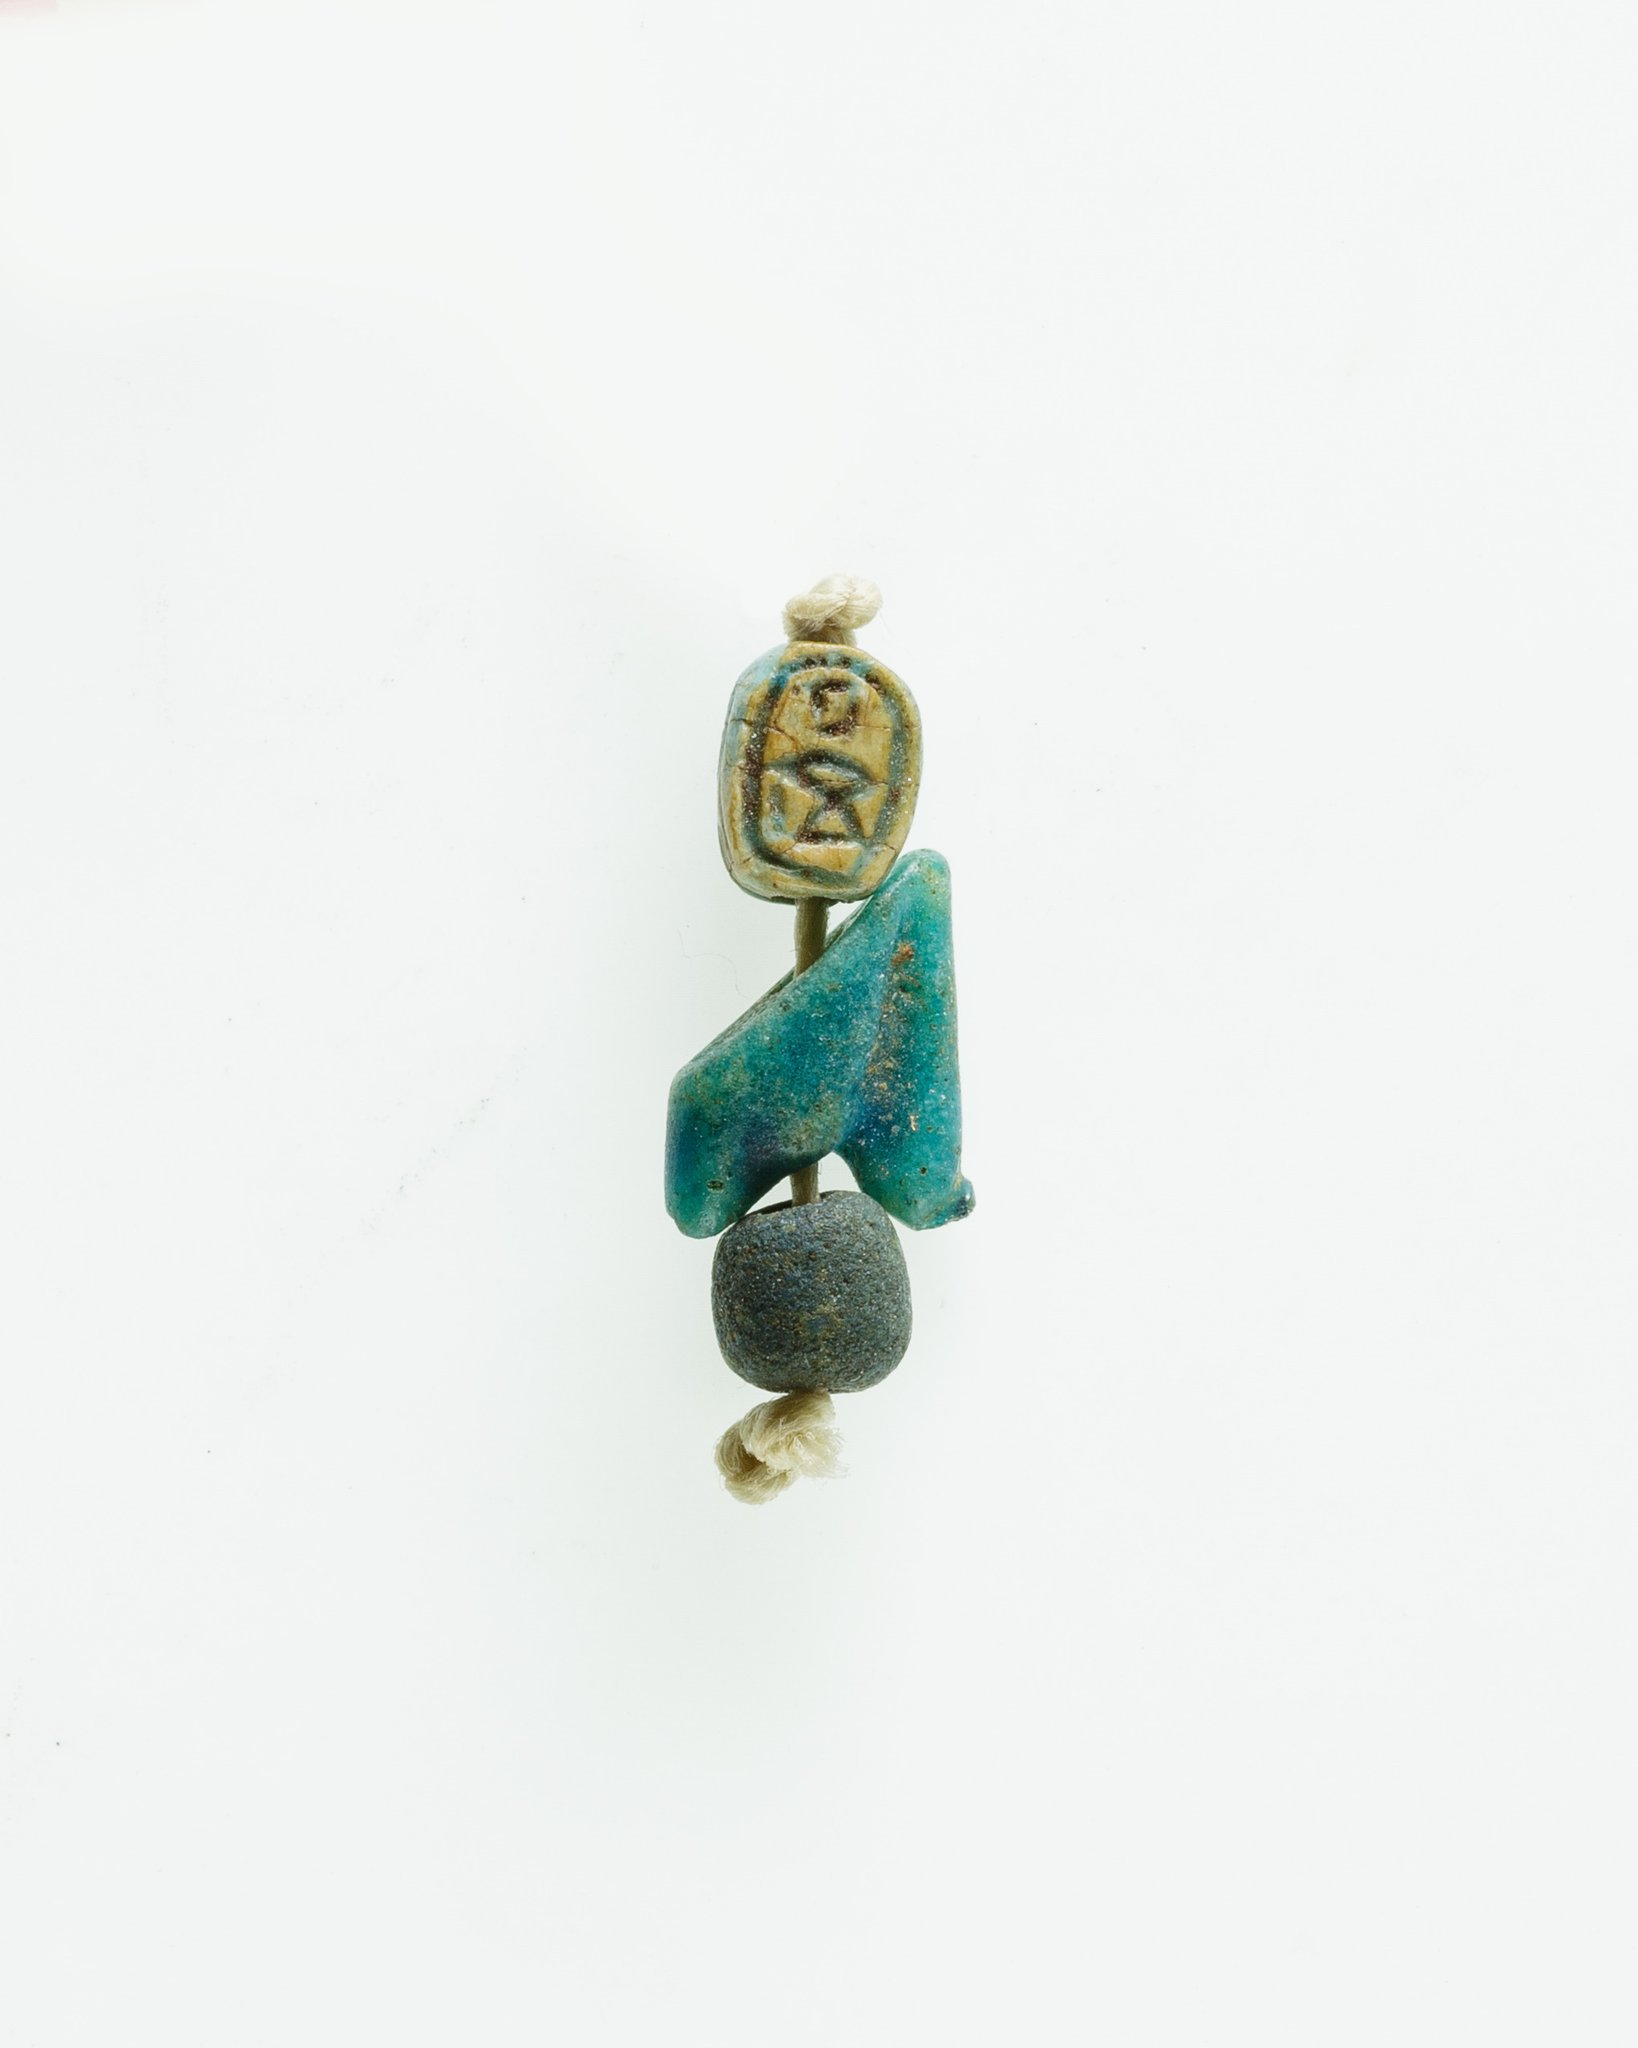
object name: bead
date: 1981-1640 BCE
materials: faience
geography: egypt